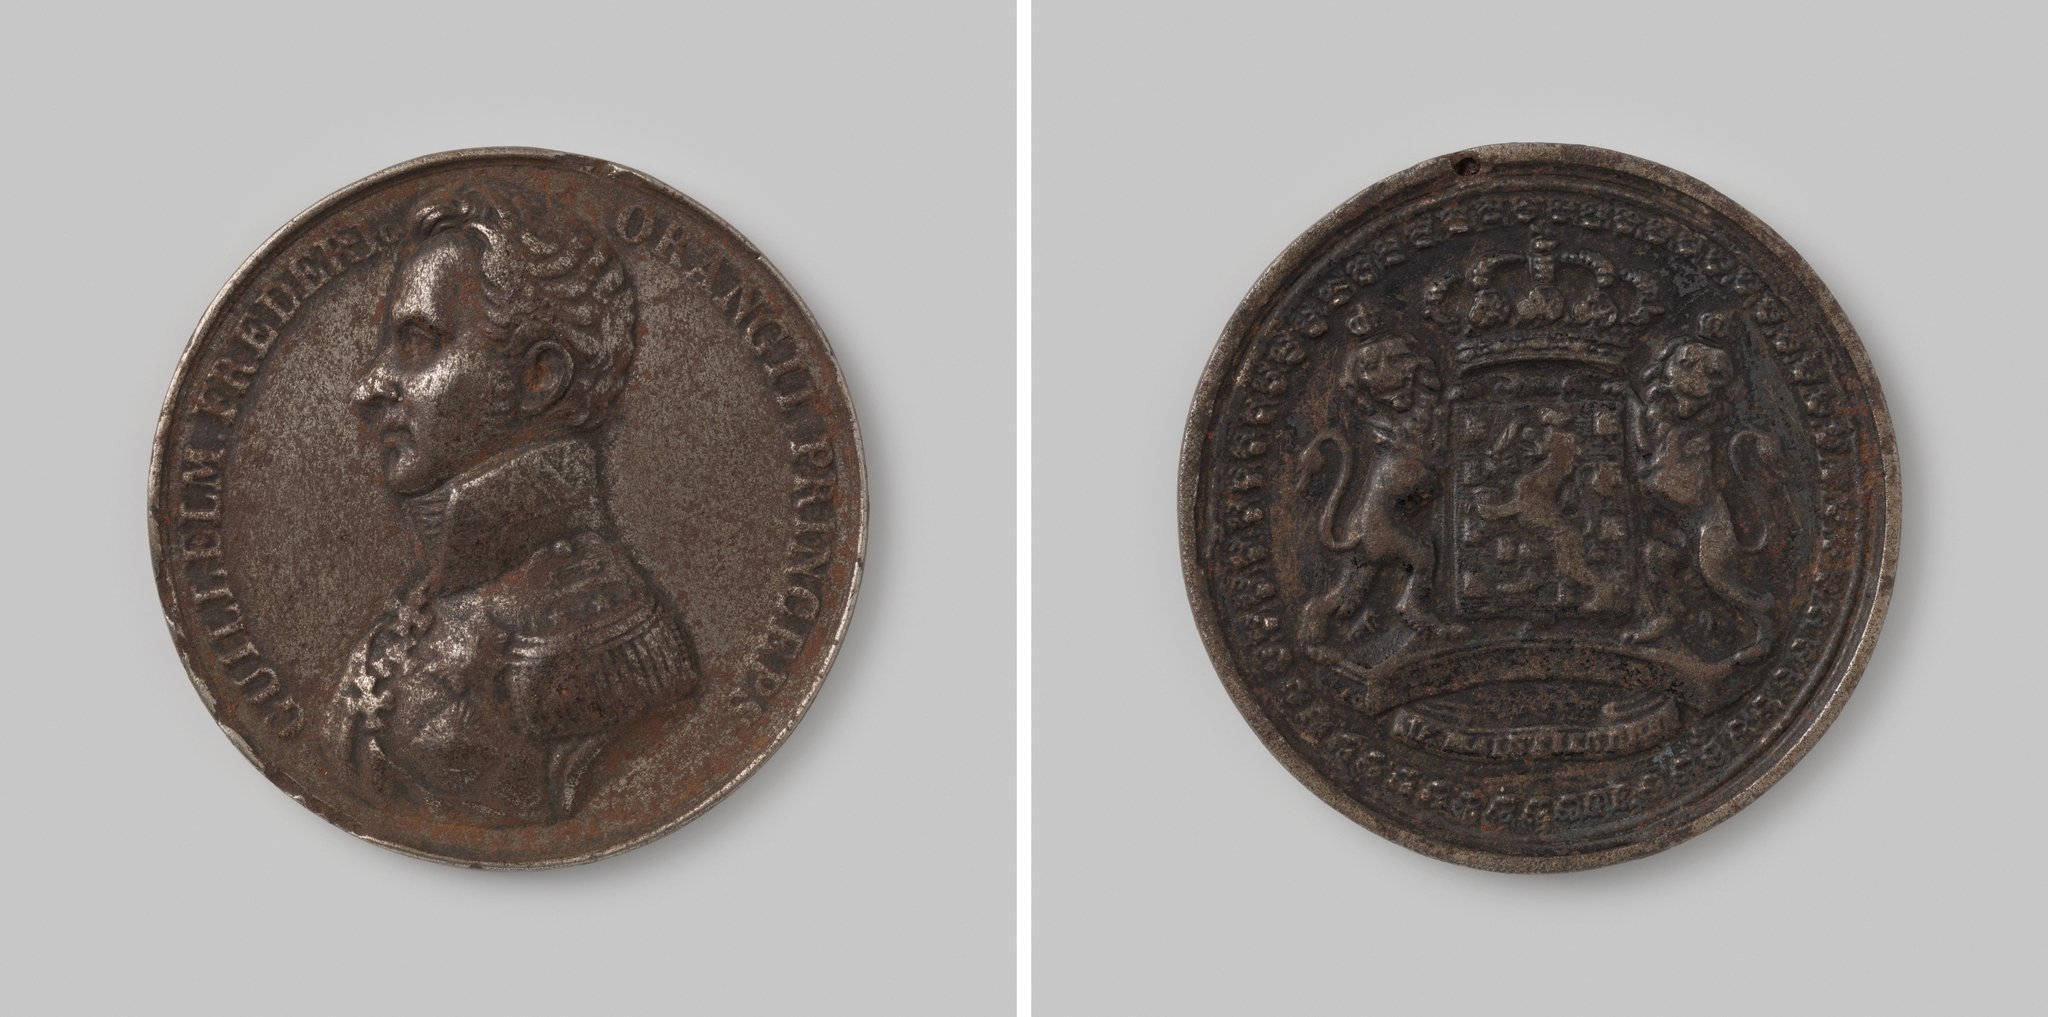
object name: history medal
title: Penning op Prins Willem Frederik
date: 1816-1834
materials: iron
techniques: casting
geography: brussels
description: IJzeren afgietsel van een penning, op de voorzijde het borstbeeld naar links van Willem Frederik, met omschrift, op de keerzijde het gekroonde Nederllandse wapen met dragers en banderol, binnen een versierde rand.